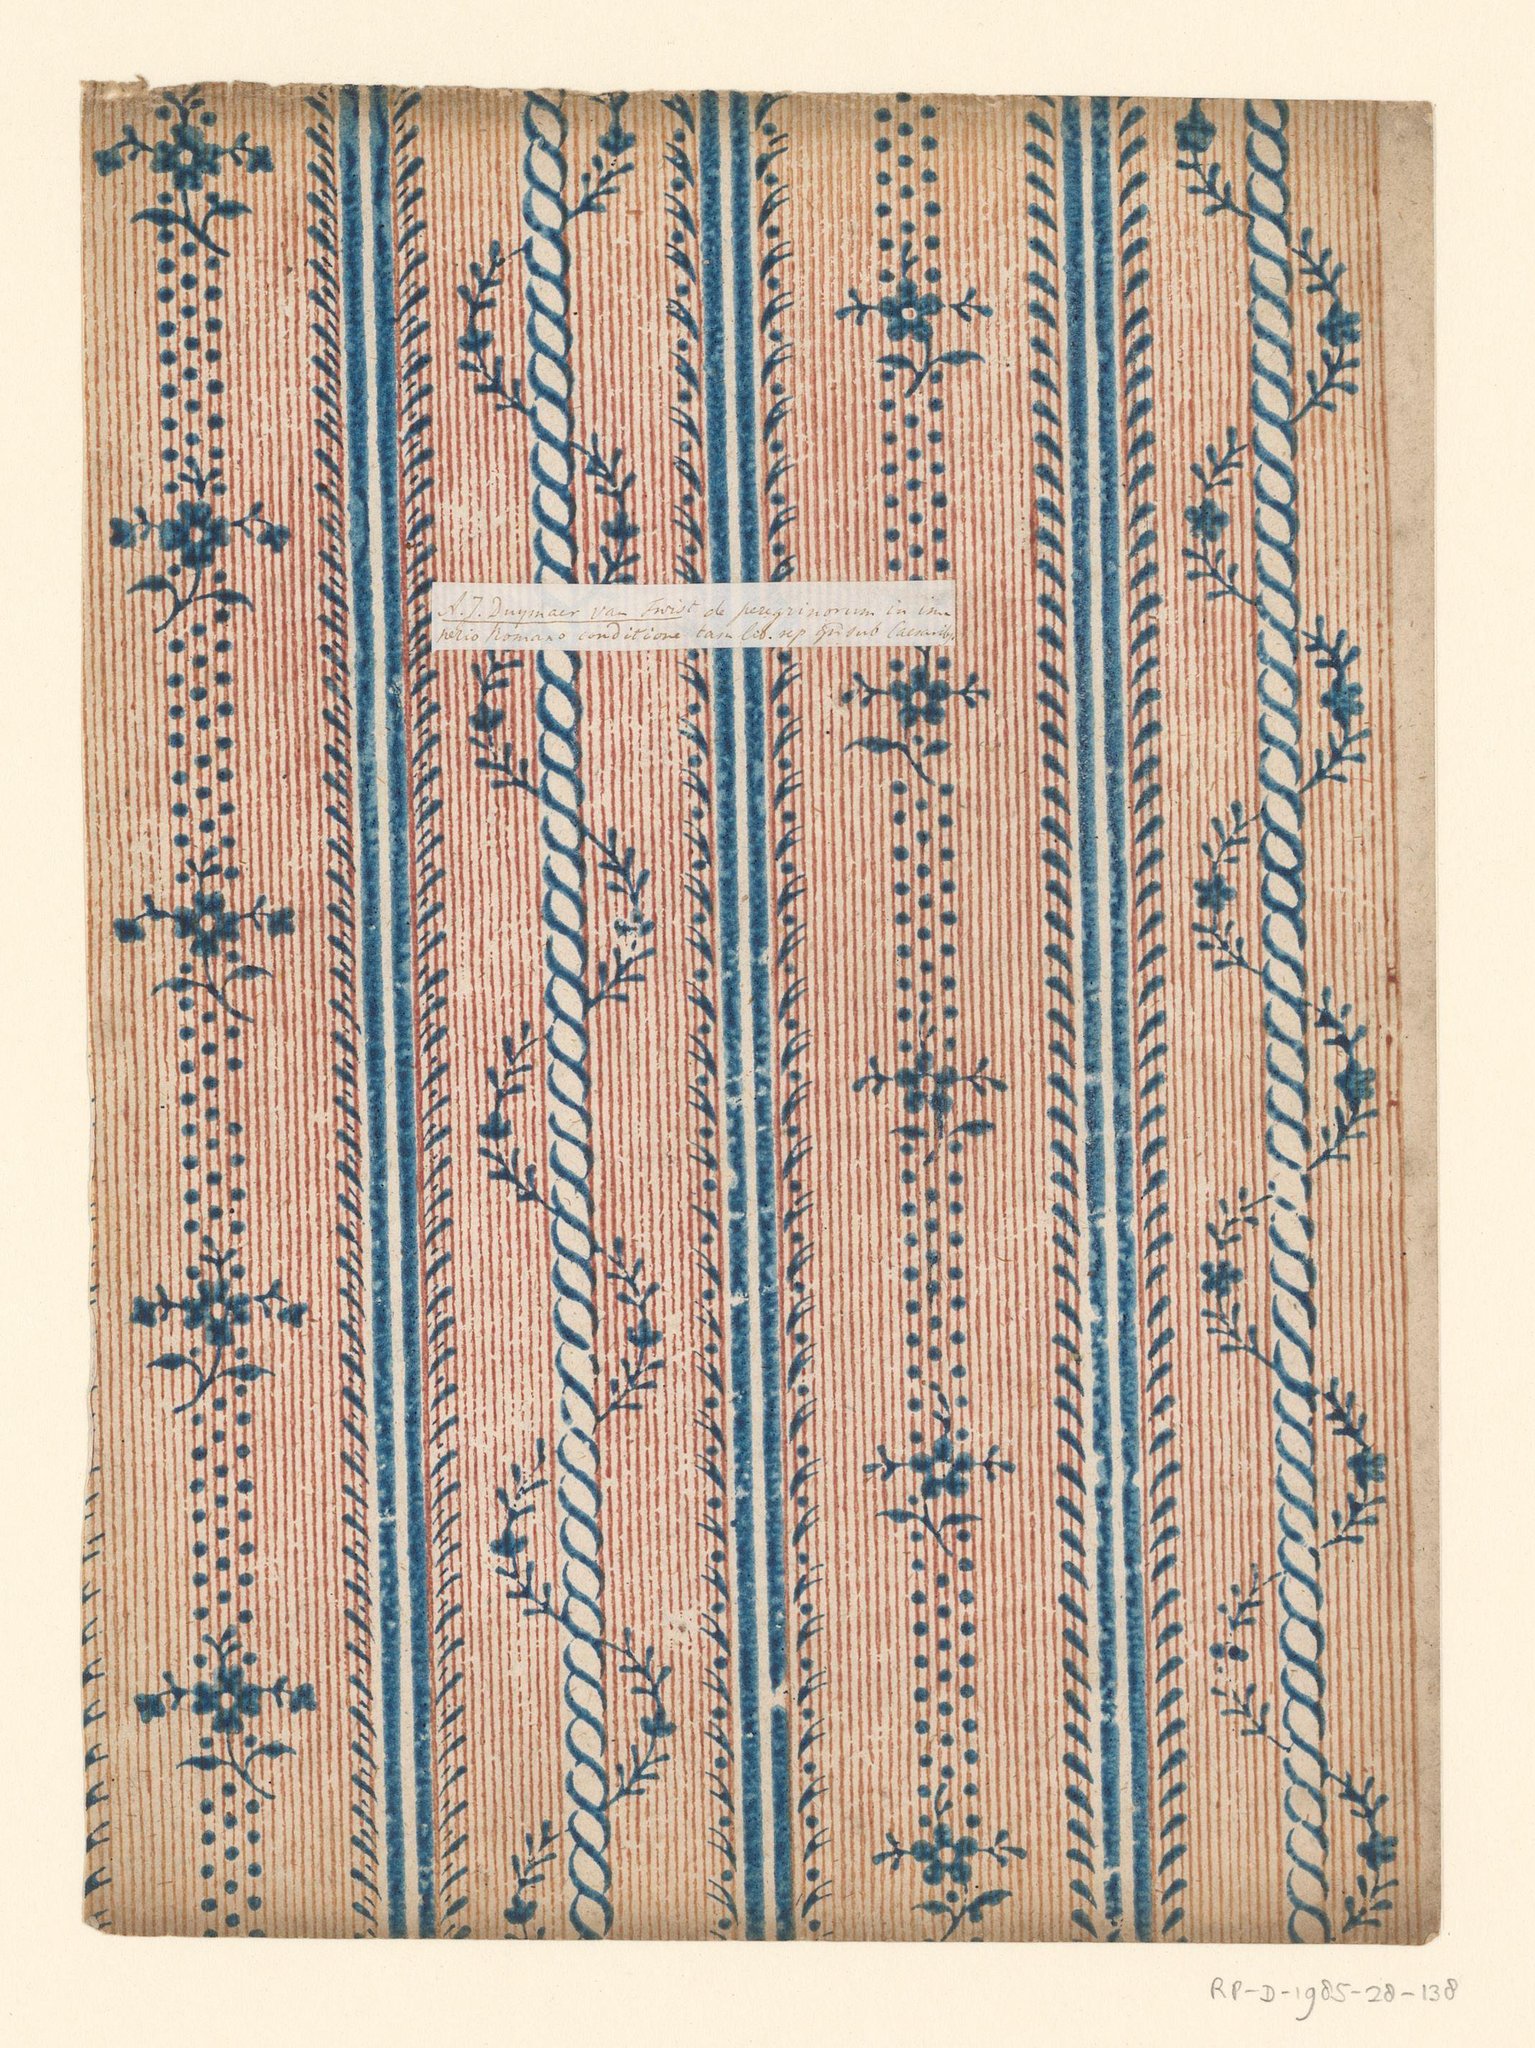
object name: printed paper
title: Blad met banenpatroon van omwonden staaf met rank alternerend met bloemtak met punten op een onderbroken lijnenfond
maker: Anonymous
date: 1750-1900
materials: paper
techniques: printing block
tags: ornament derived from plant forms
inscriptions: collector's mark: Lugt 2760, collector's mark: Lugt 2228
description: Blad met verticaal banenpatroon van omwonden staaf met rank alternerend met bloemtak met punten op een onderbroken lijnenfond. Met etiket met opschrift: 'A.J. Duynaer van Twist ... Caesari... .' Helft van een omslag.